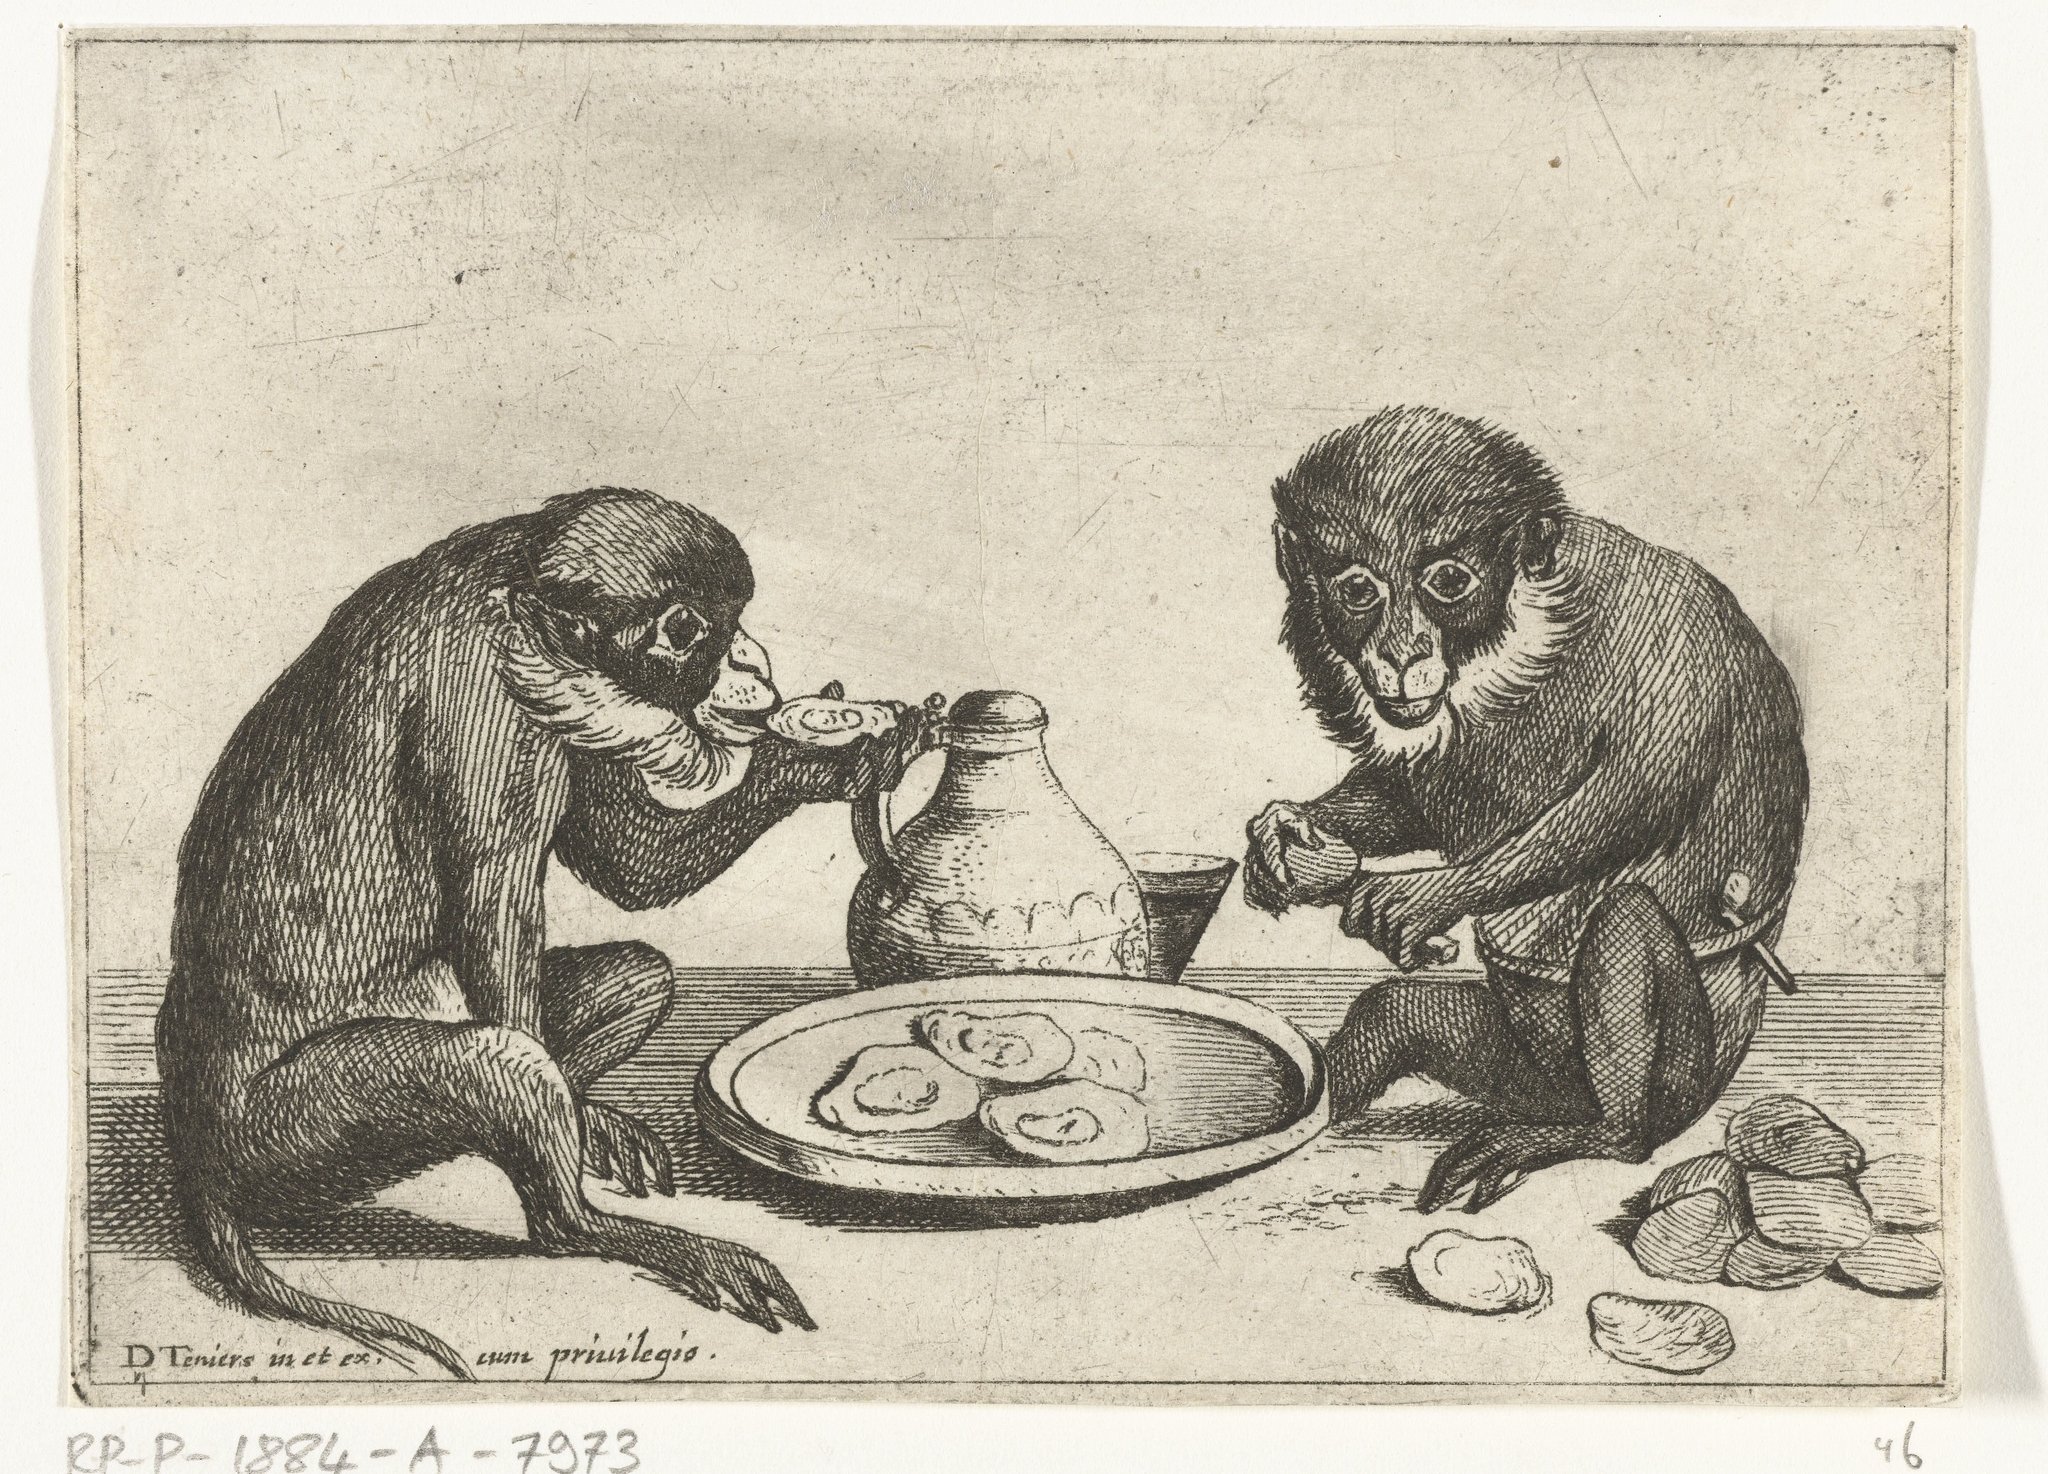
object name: print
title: het Apespel inde werelt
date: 1635-1690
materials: paper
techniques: etching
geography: southern netherlands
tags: animals acting as human beings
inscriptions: collector's mark: Lugt 2228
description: Twee apen zitten op de grond voor een schaal met oesters. De ene opent net een oester met een mesje, de andere slurpt een oester naar binnen. Prent uit een serie van zes prenten en een titelprent waarin verschillende menselijke bezigheden door apen voorgesteld worden.